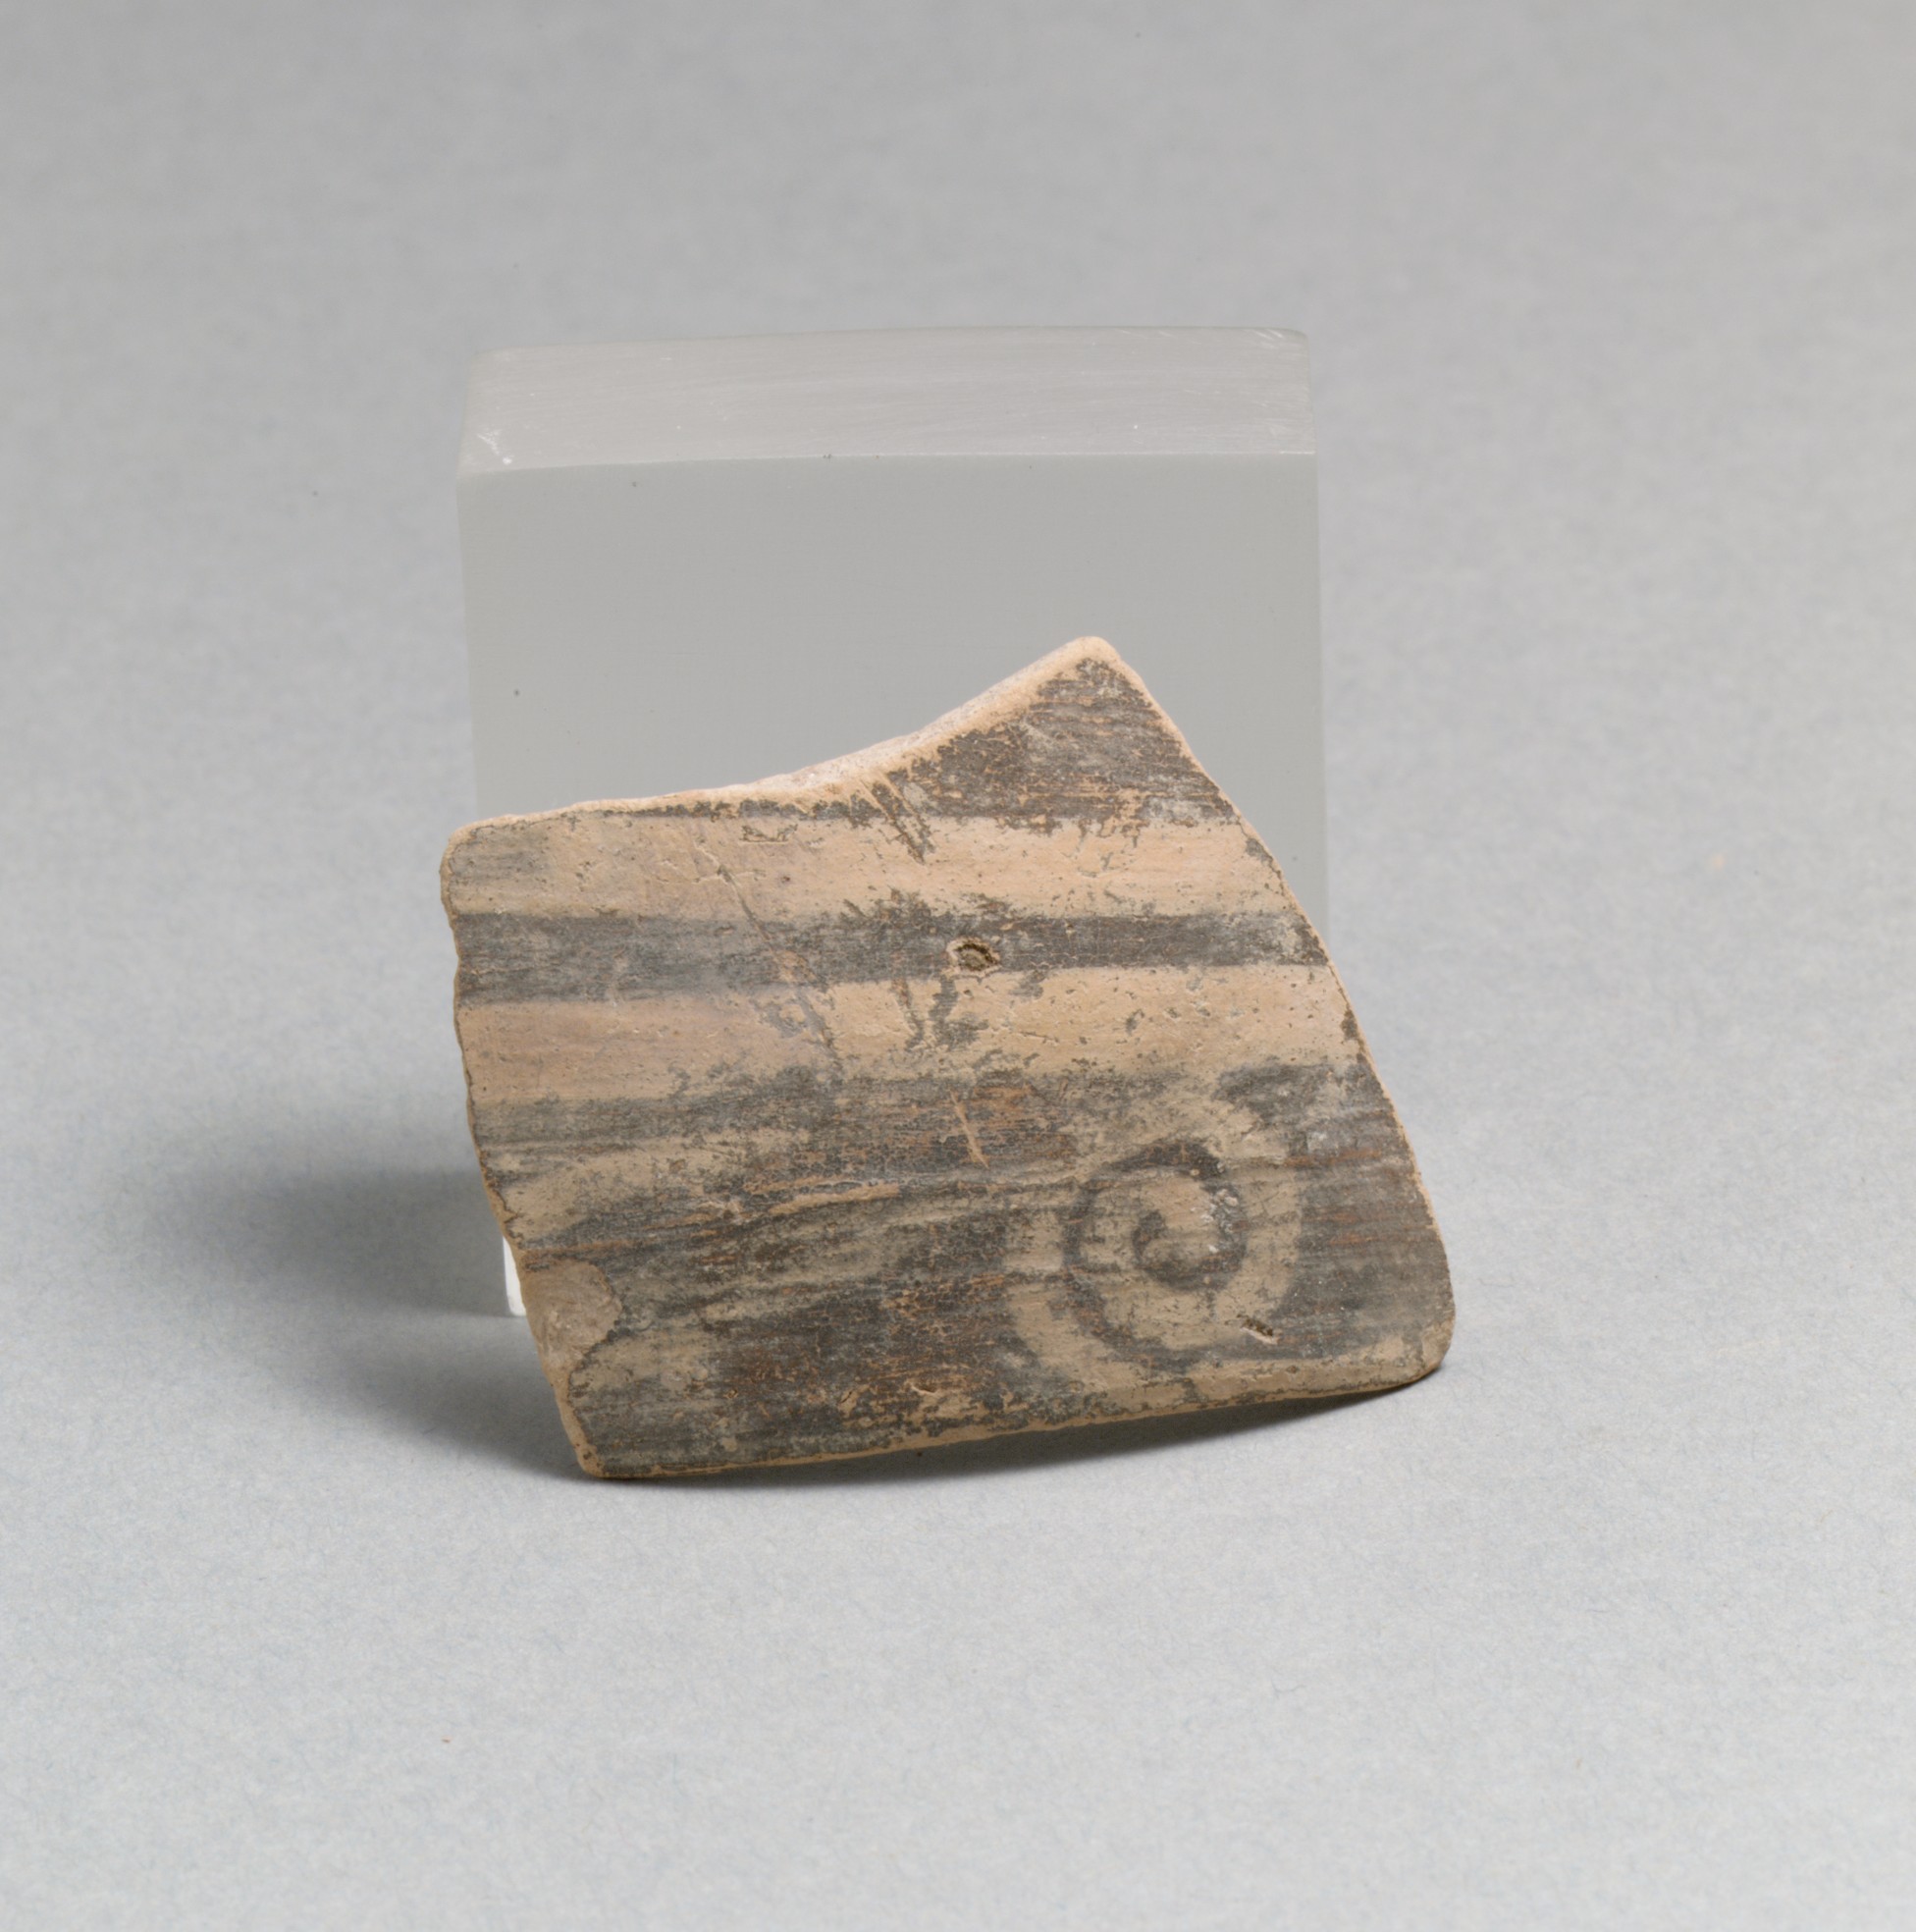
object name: vase fragment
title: Terracotta rim fragment with running spiral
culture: minoan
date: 2300-2100 BCE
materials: terracotta